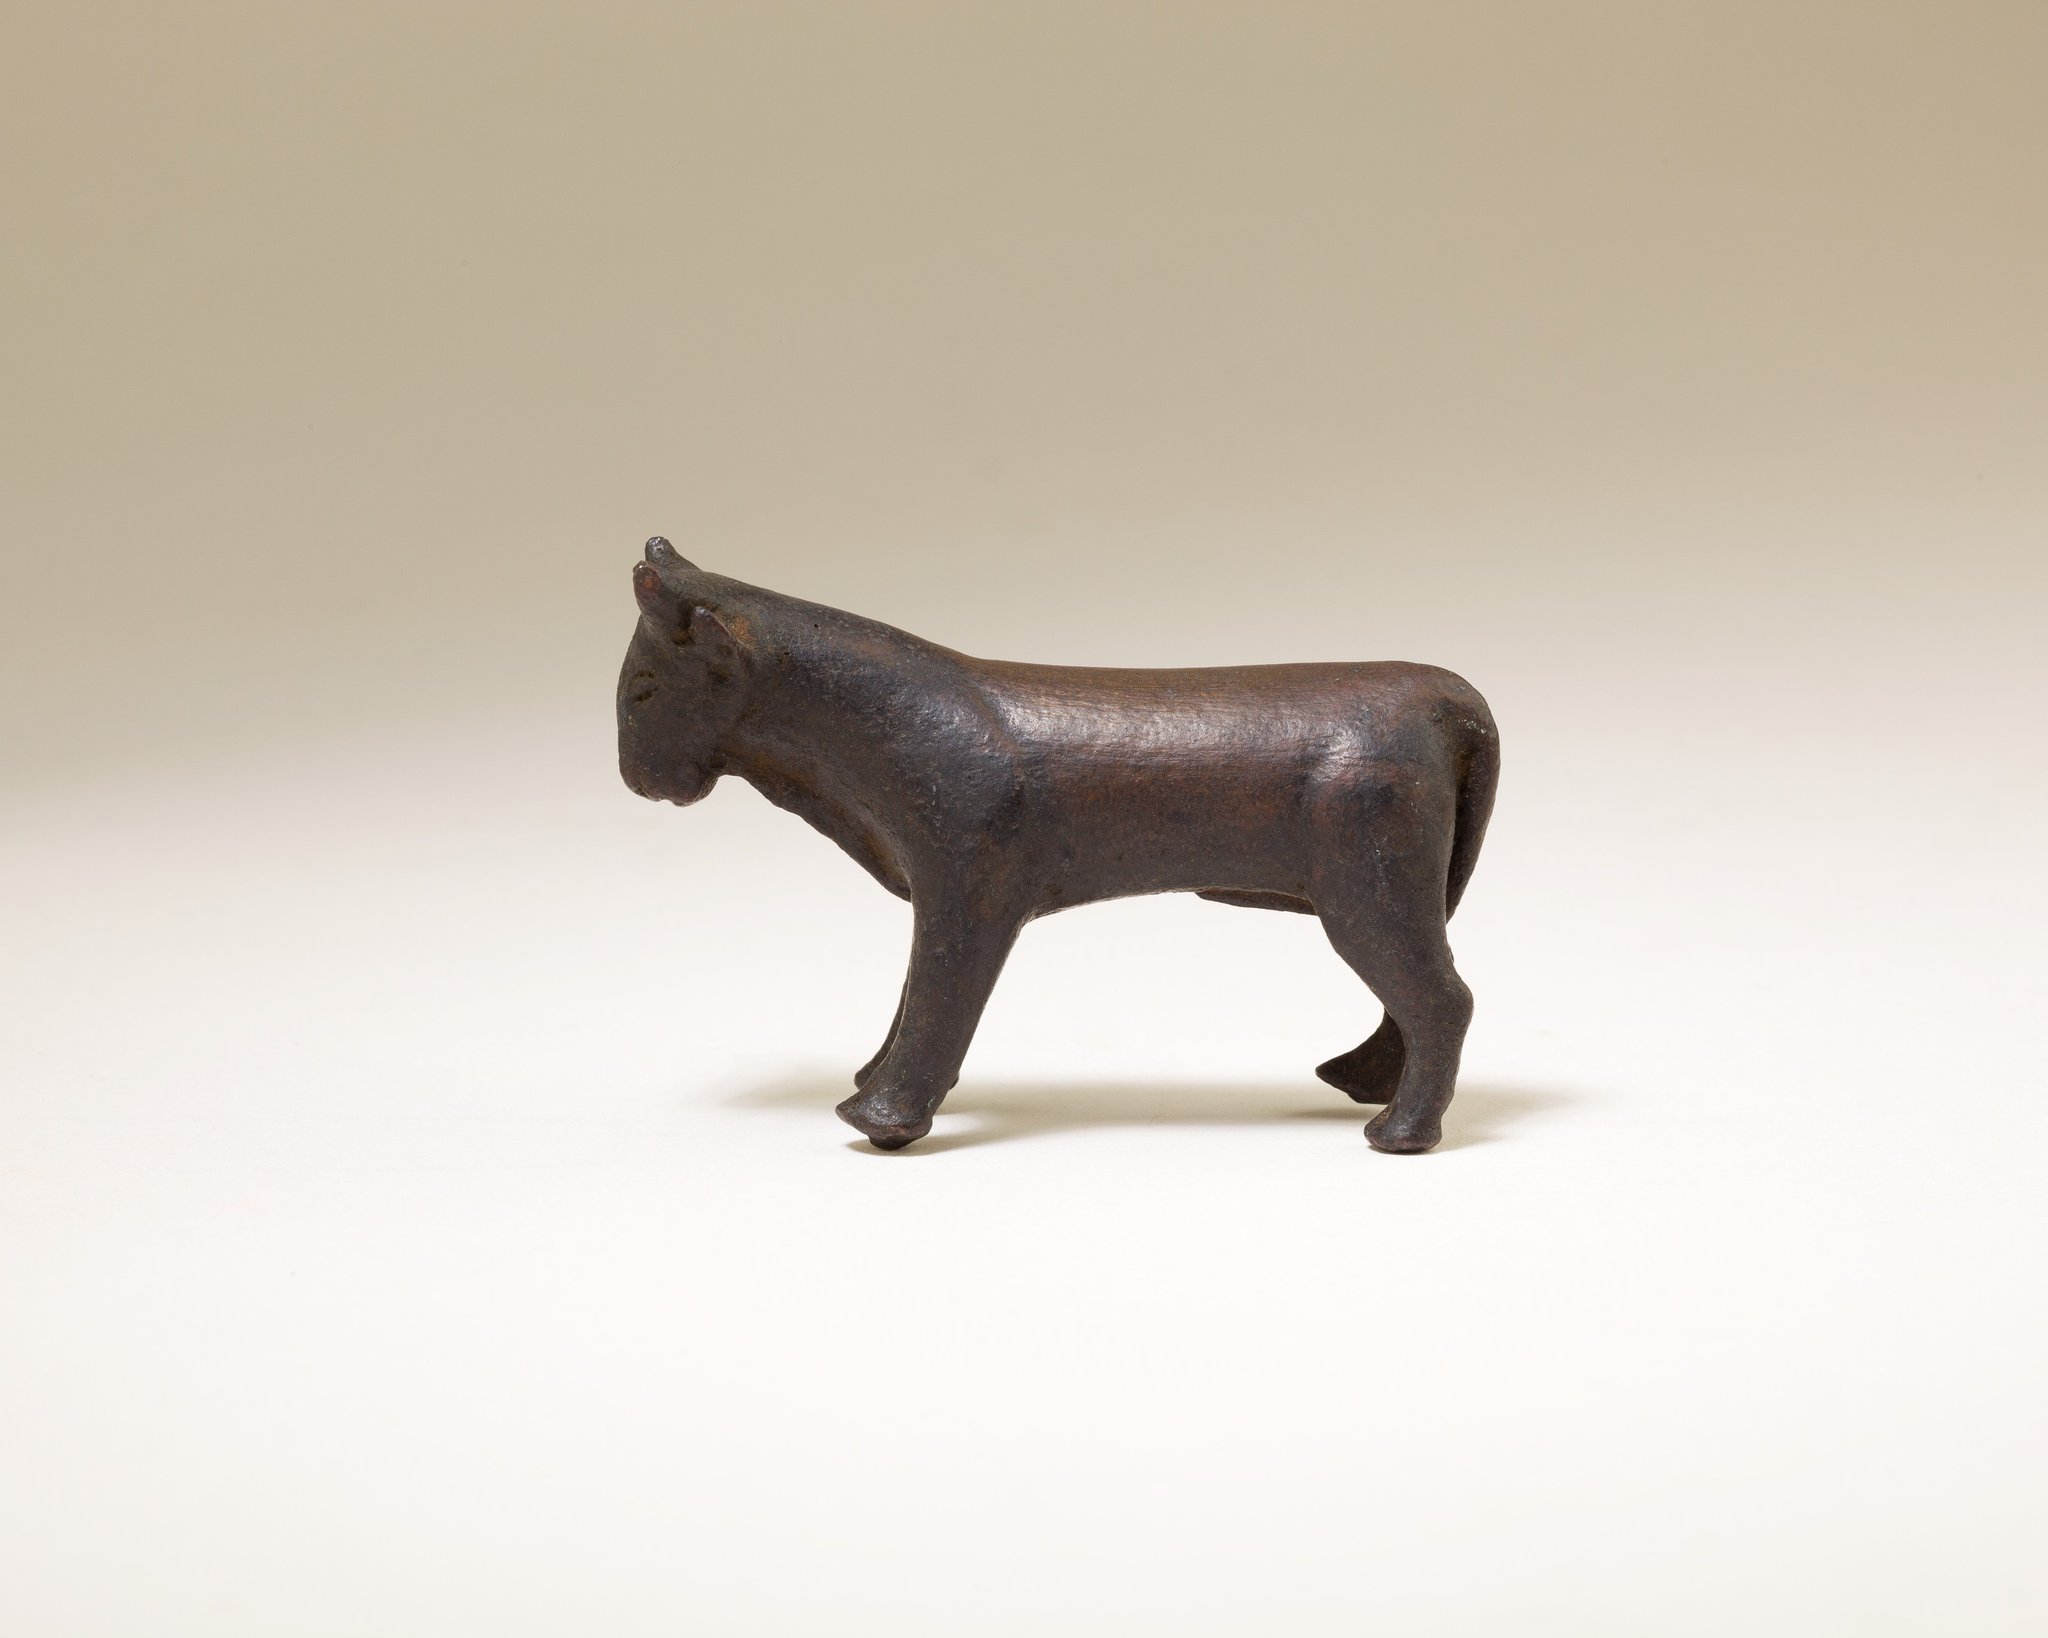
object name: figurine, apis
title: Apis(?)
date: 664-630 BCE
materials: metal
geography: egypt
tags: bulls